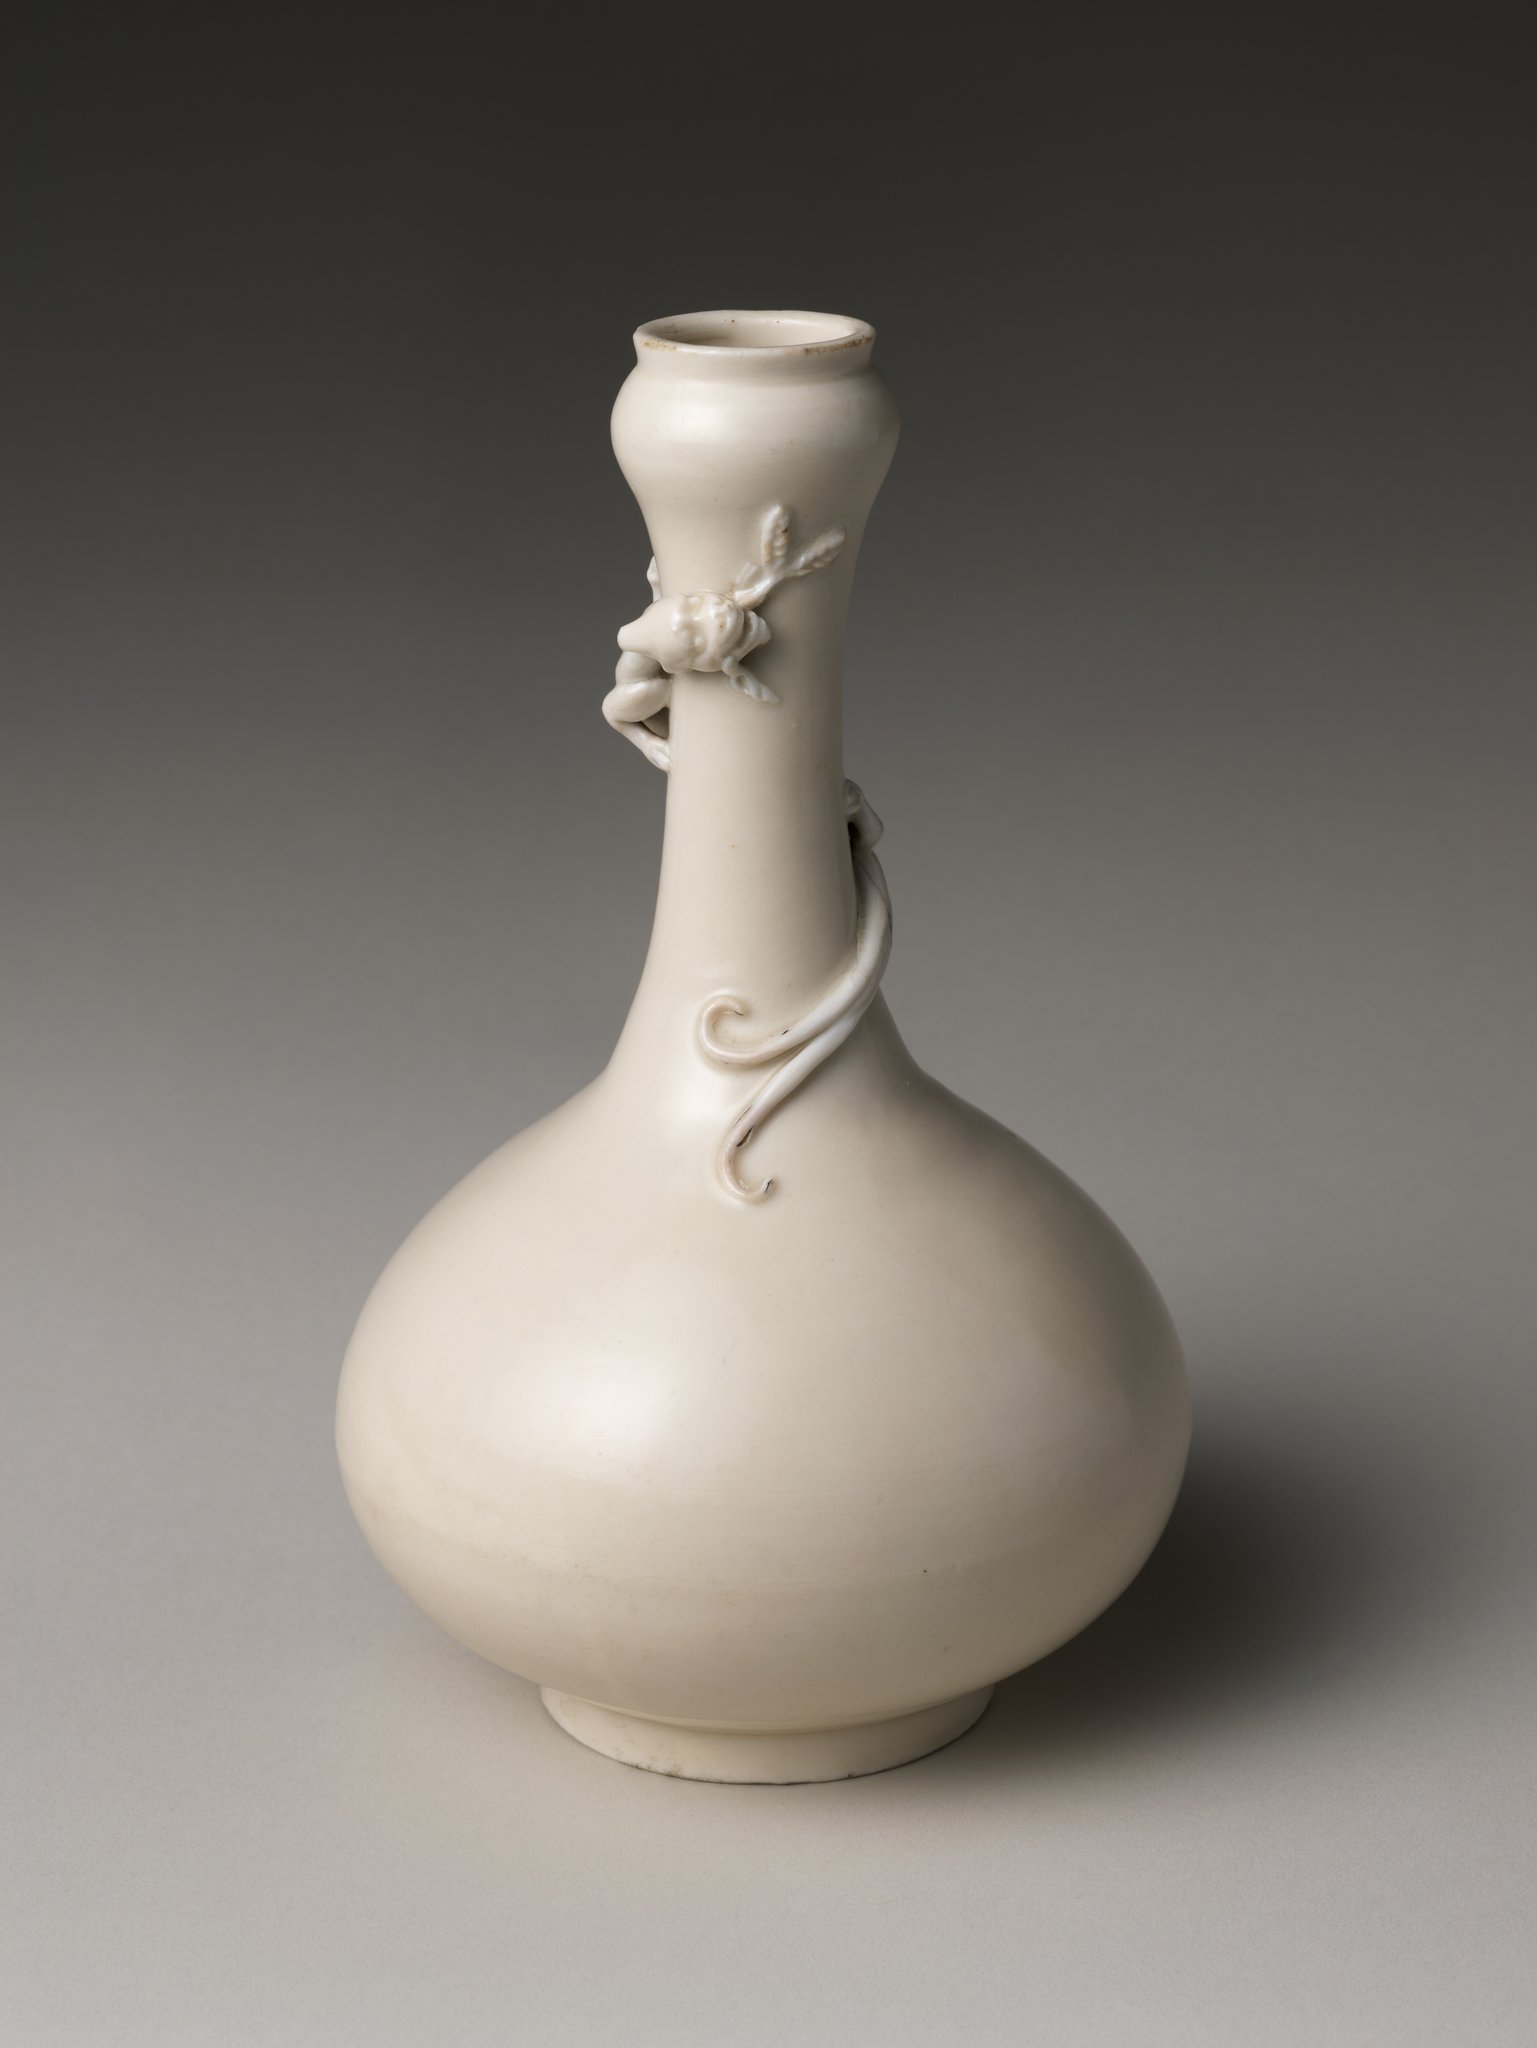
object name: bottle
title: Bottle with Coiling Dragon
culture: chinese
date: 1567-1600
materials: glaze, porcelain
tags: dragons